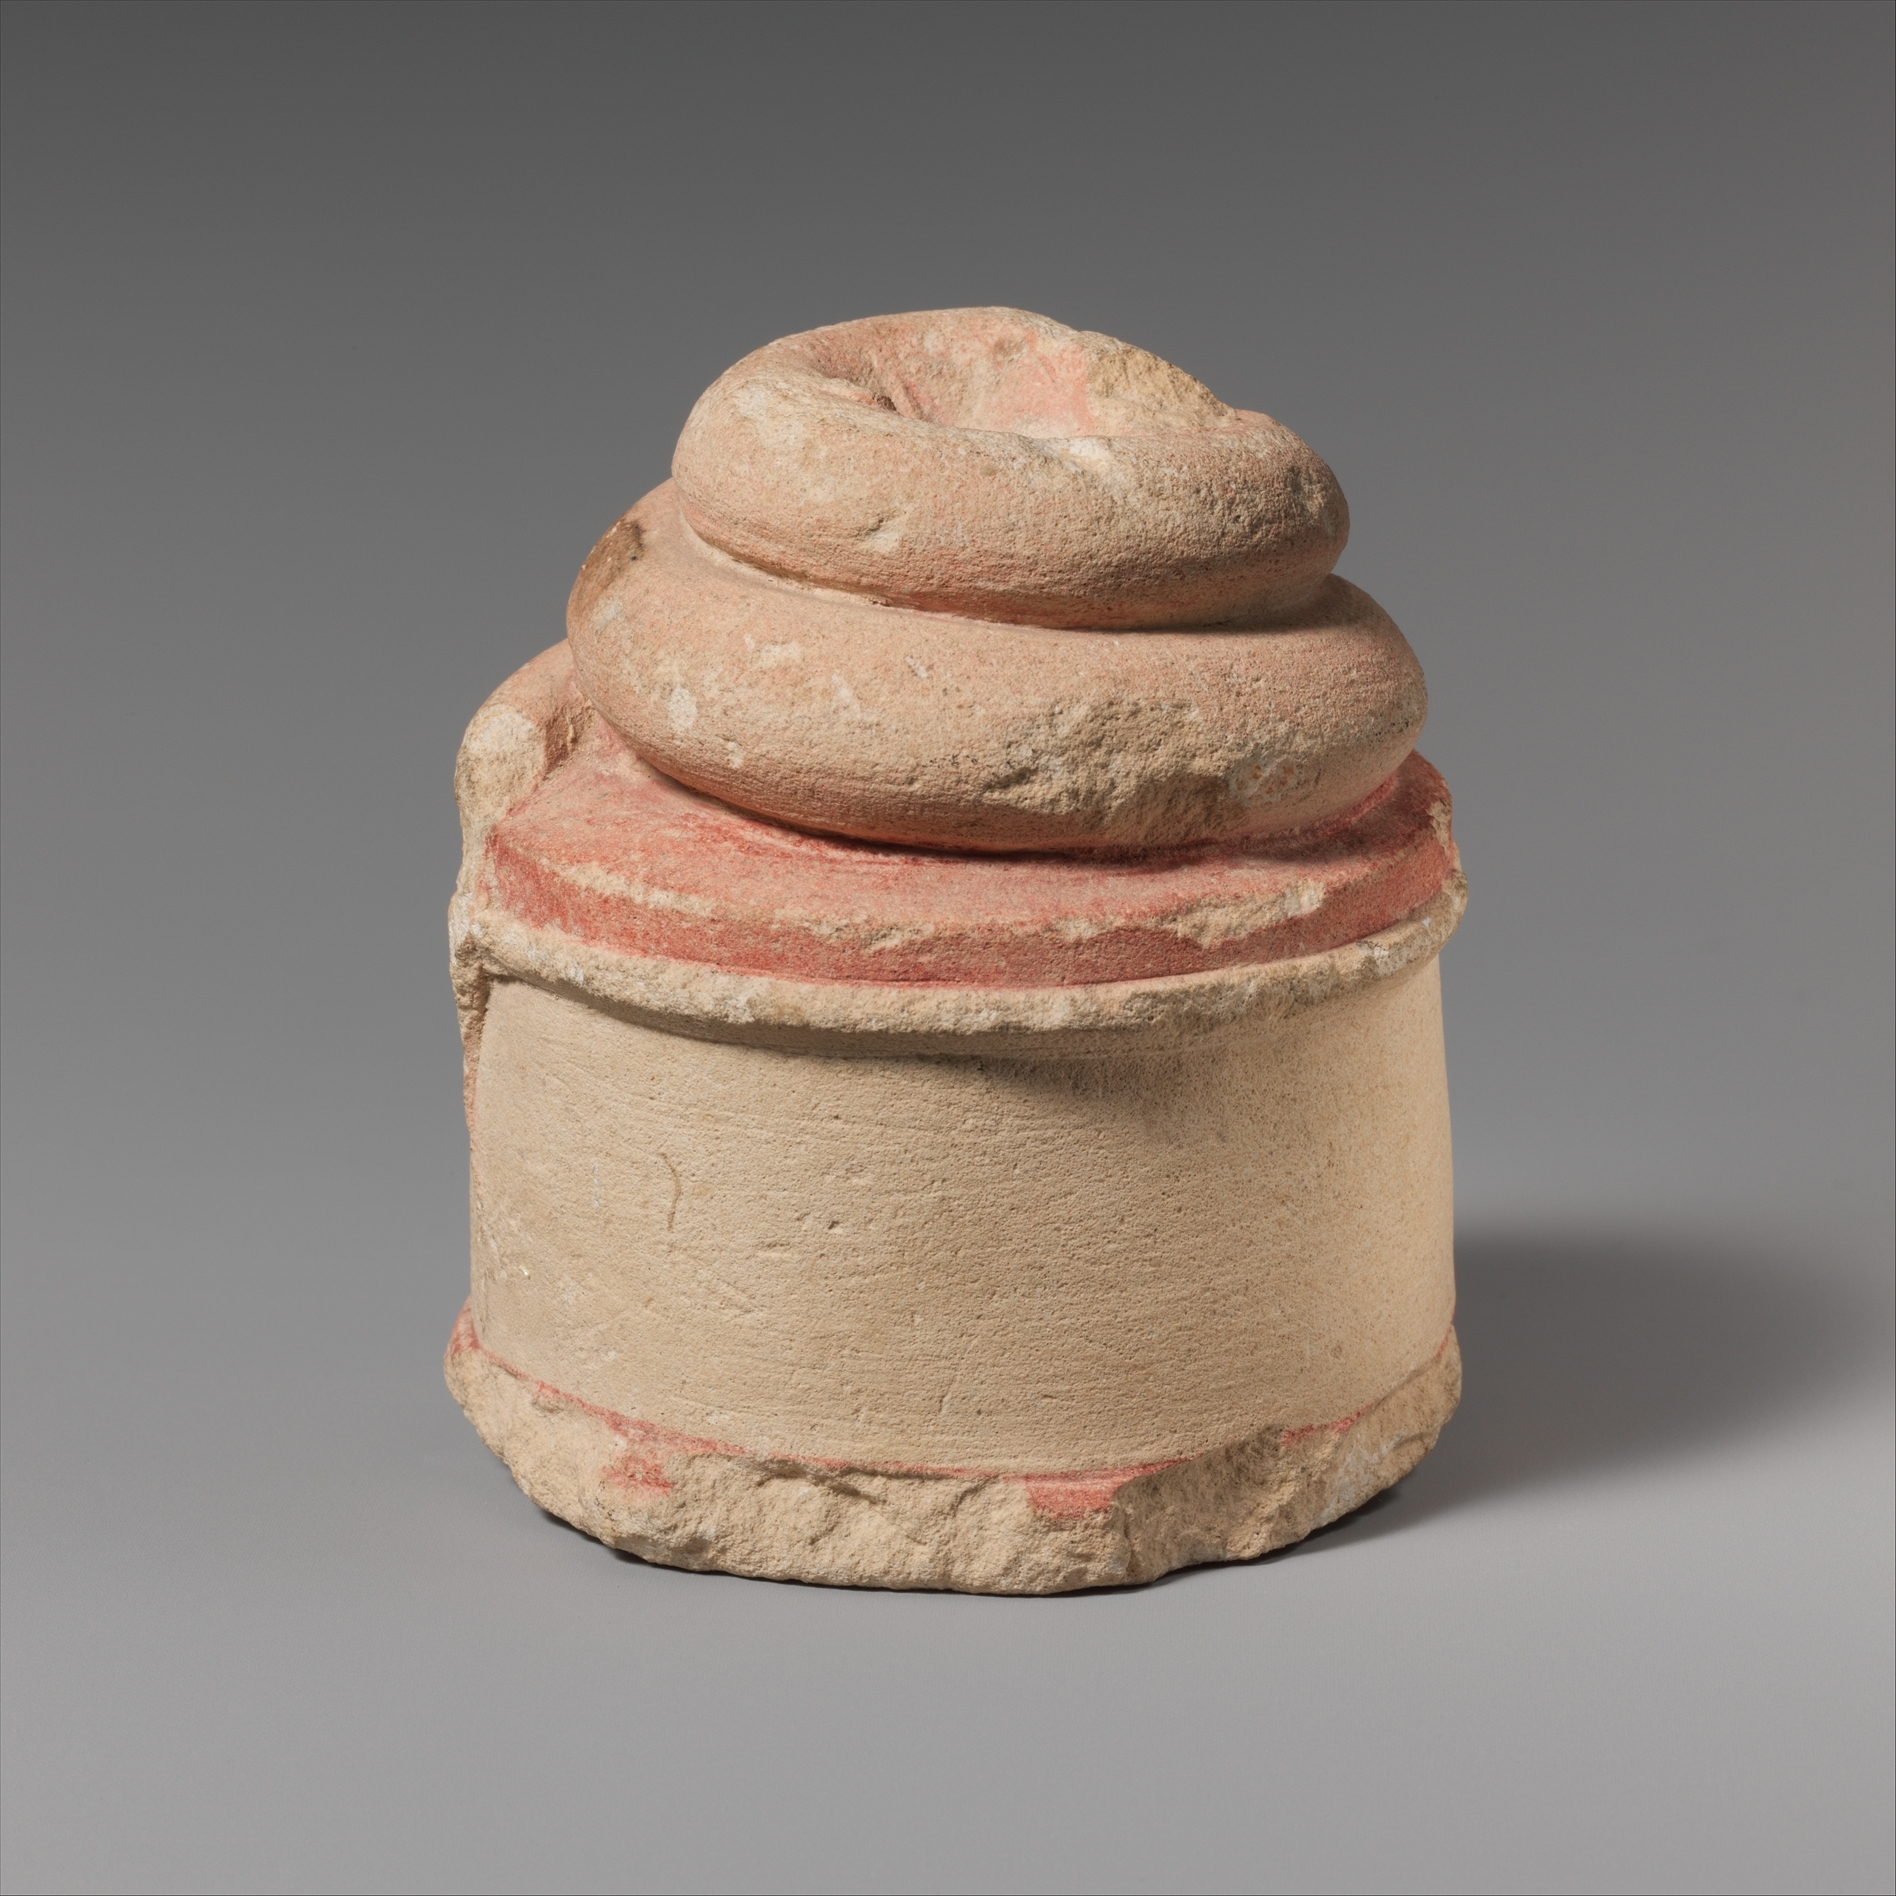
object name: altar shrine with snake coiled on low pedestal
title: Limestone altar or pedestal with coiled snake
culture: cypriot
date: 500-401 BCE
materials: limestone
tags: snakes